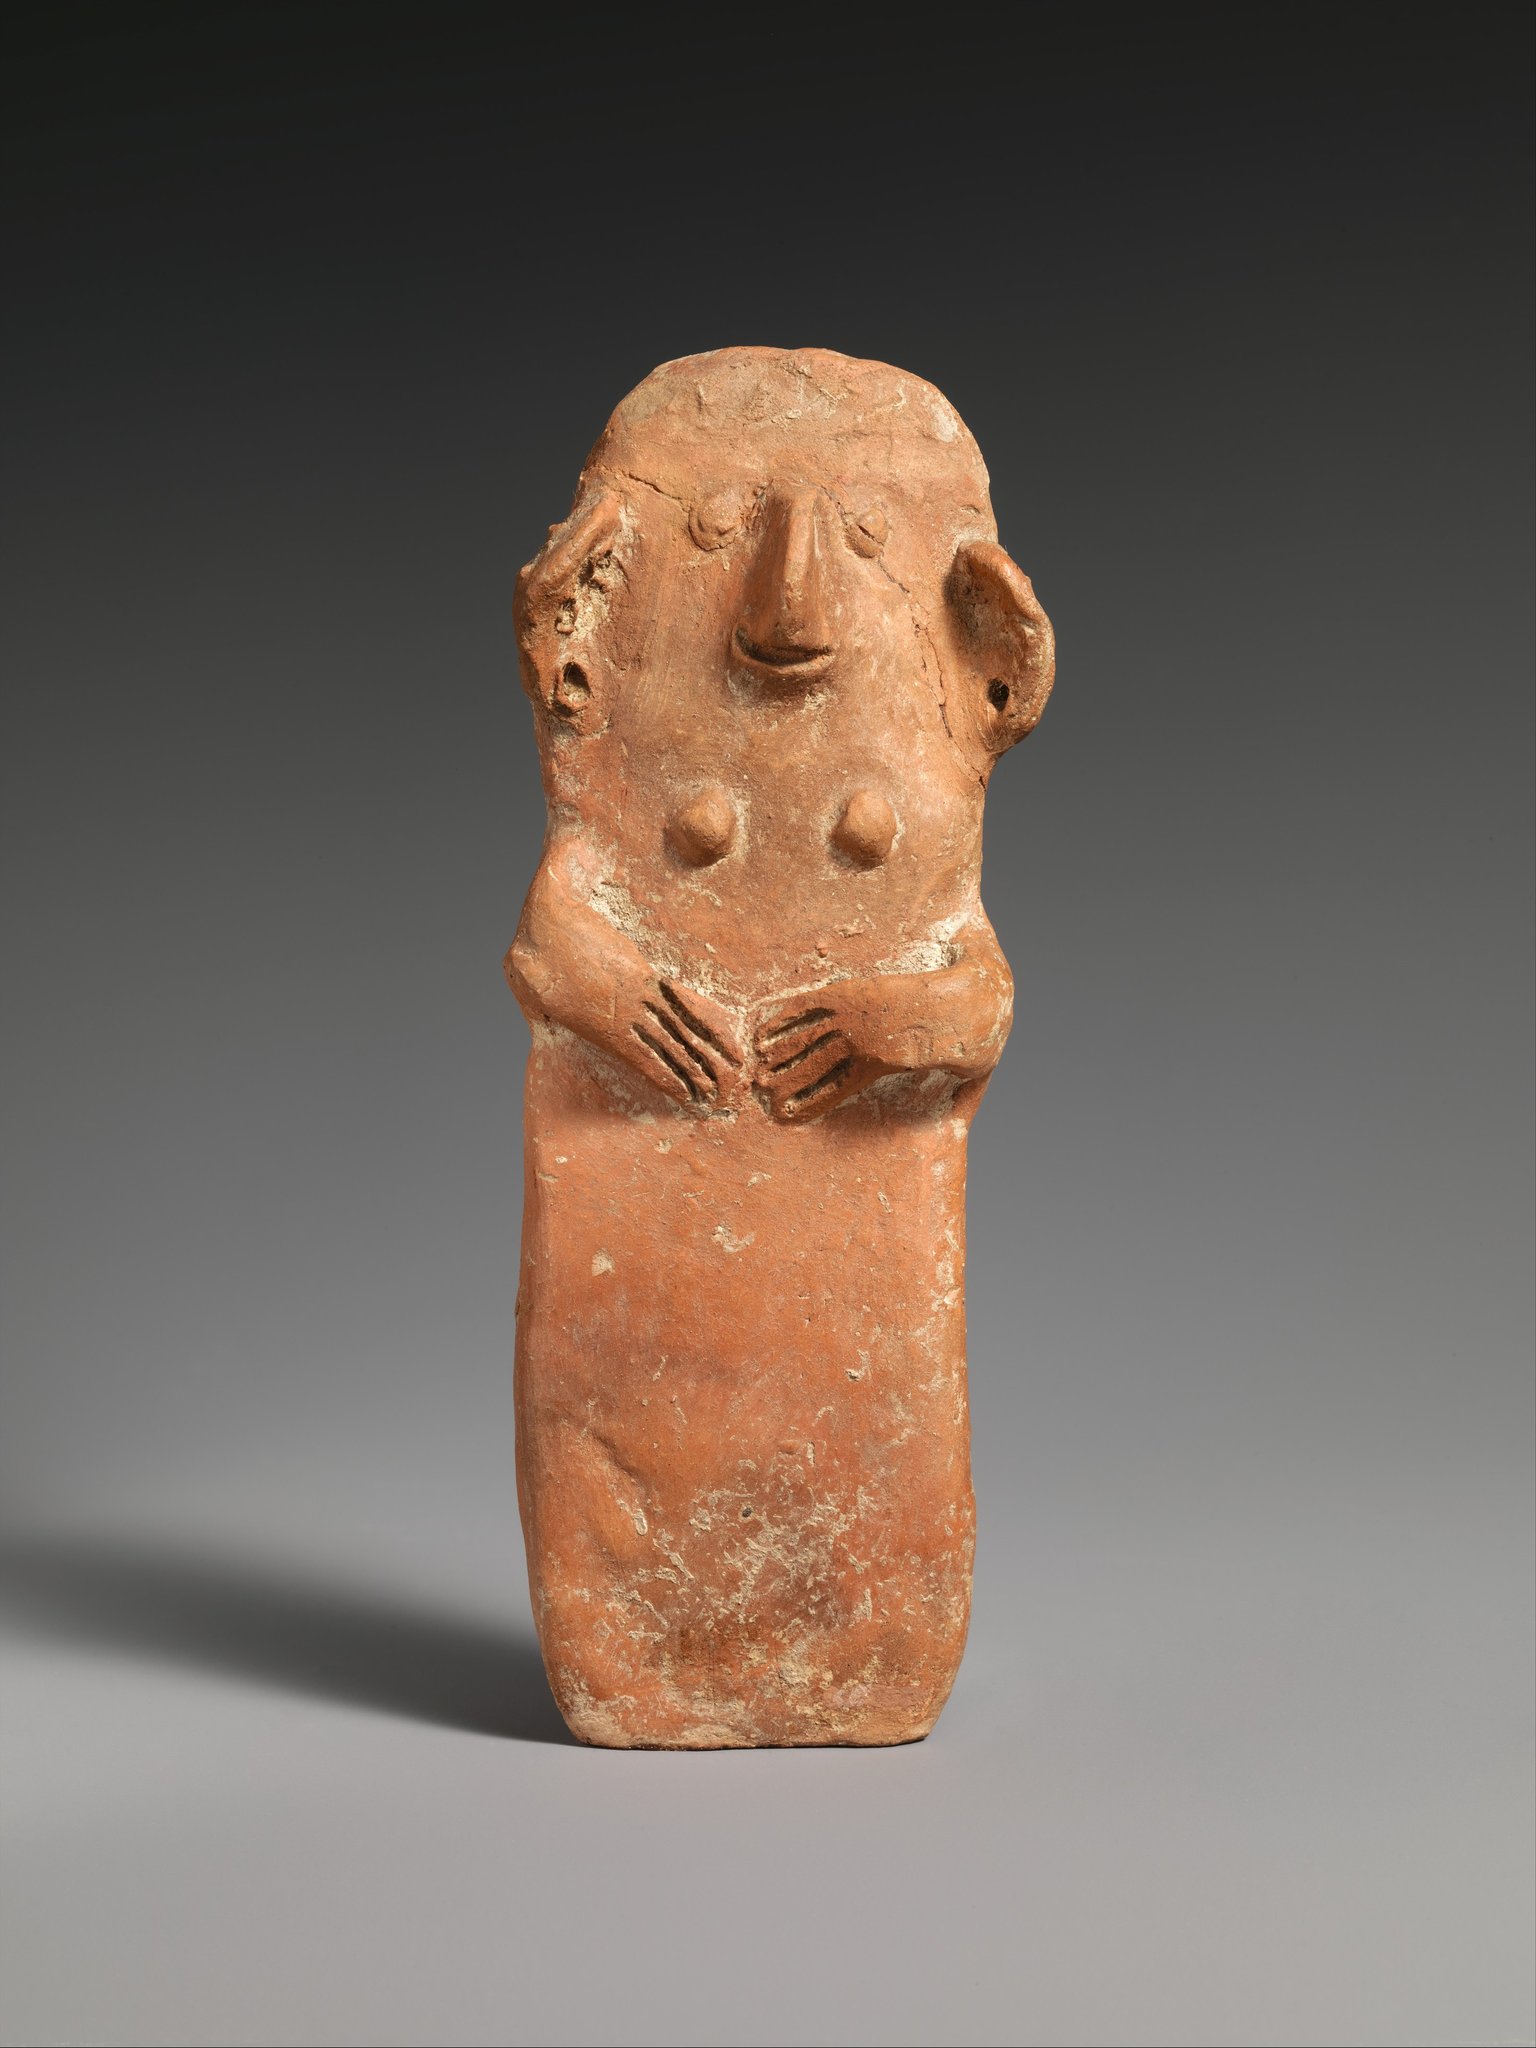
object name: figurine of a woman, plank shaped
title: Terracotta plank-shaped figurine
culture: cypriot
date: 1900-1800 BCE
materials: terracotta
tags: human figures